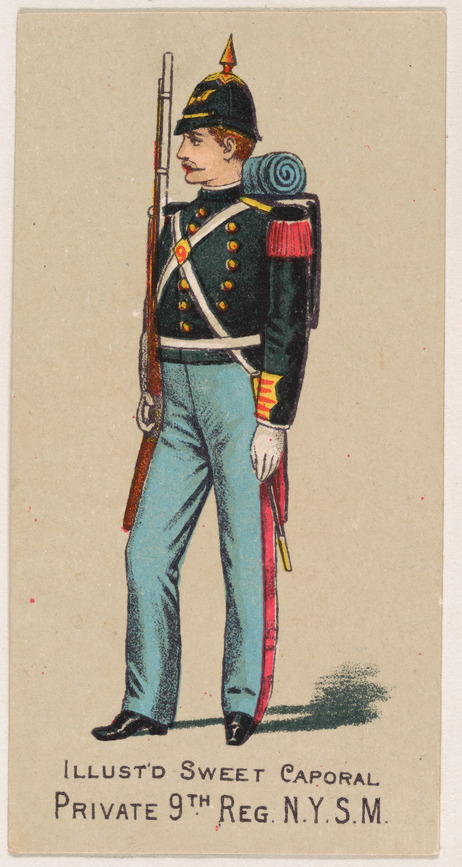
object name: print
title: Private, 9th Regiment, New York State Militia, from the Military Series (N224) issued by Kinney Tobacco Company to promote Sweet Caporal Cigarettes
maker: kinney brothers tobacco company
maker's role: publisher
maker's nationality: american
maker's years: 1869-2011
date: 1888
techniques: color lithograph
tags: military,firearms,men,profiles